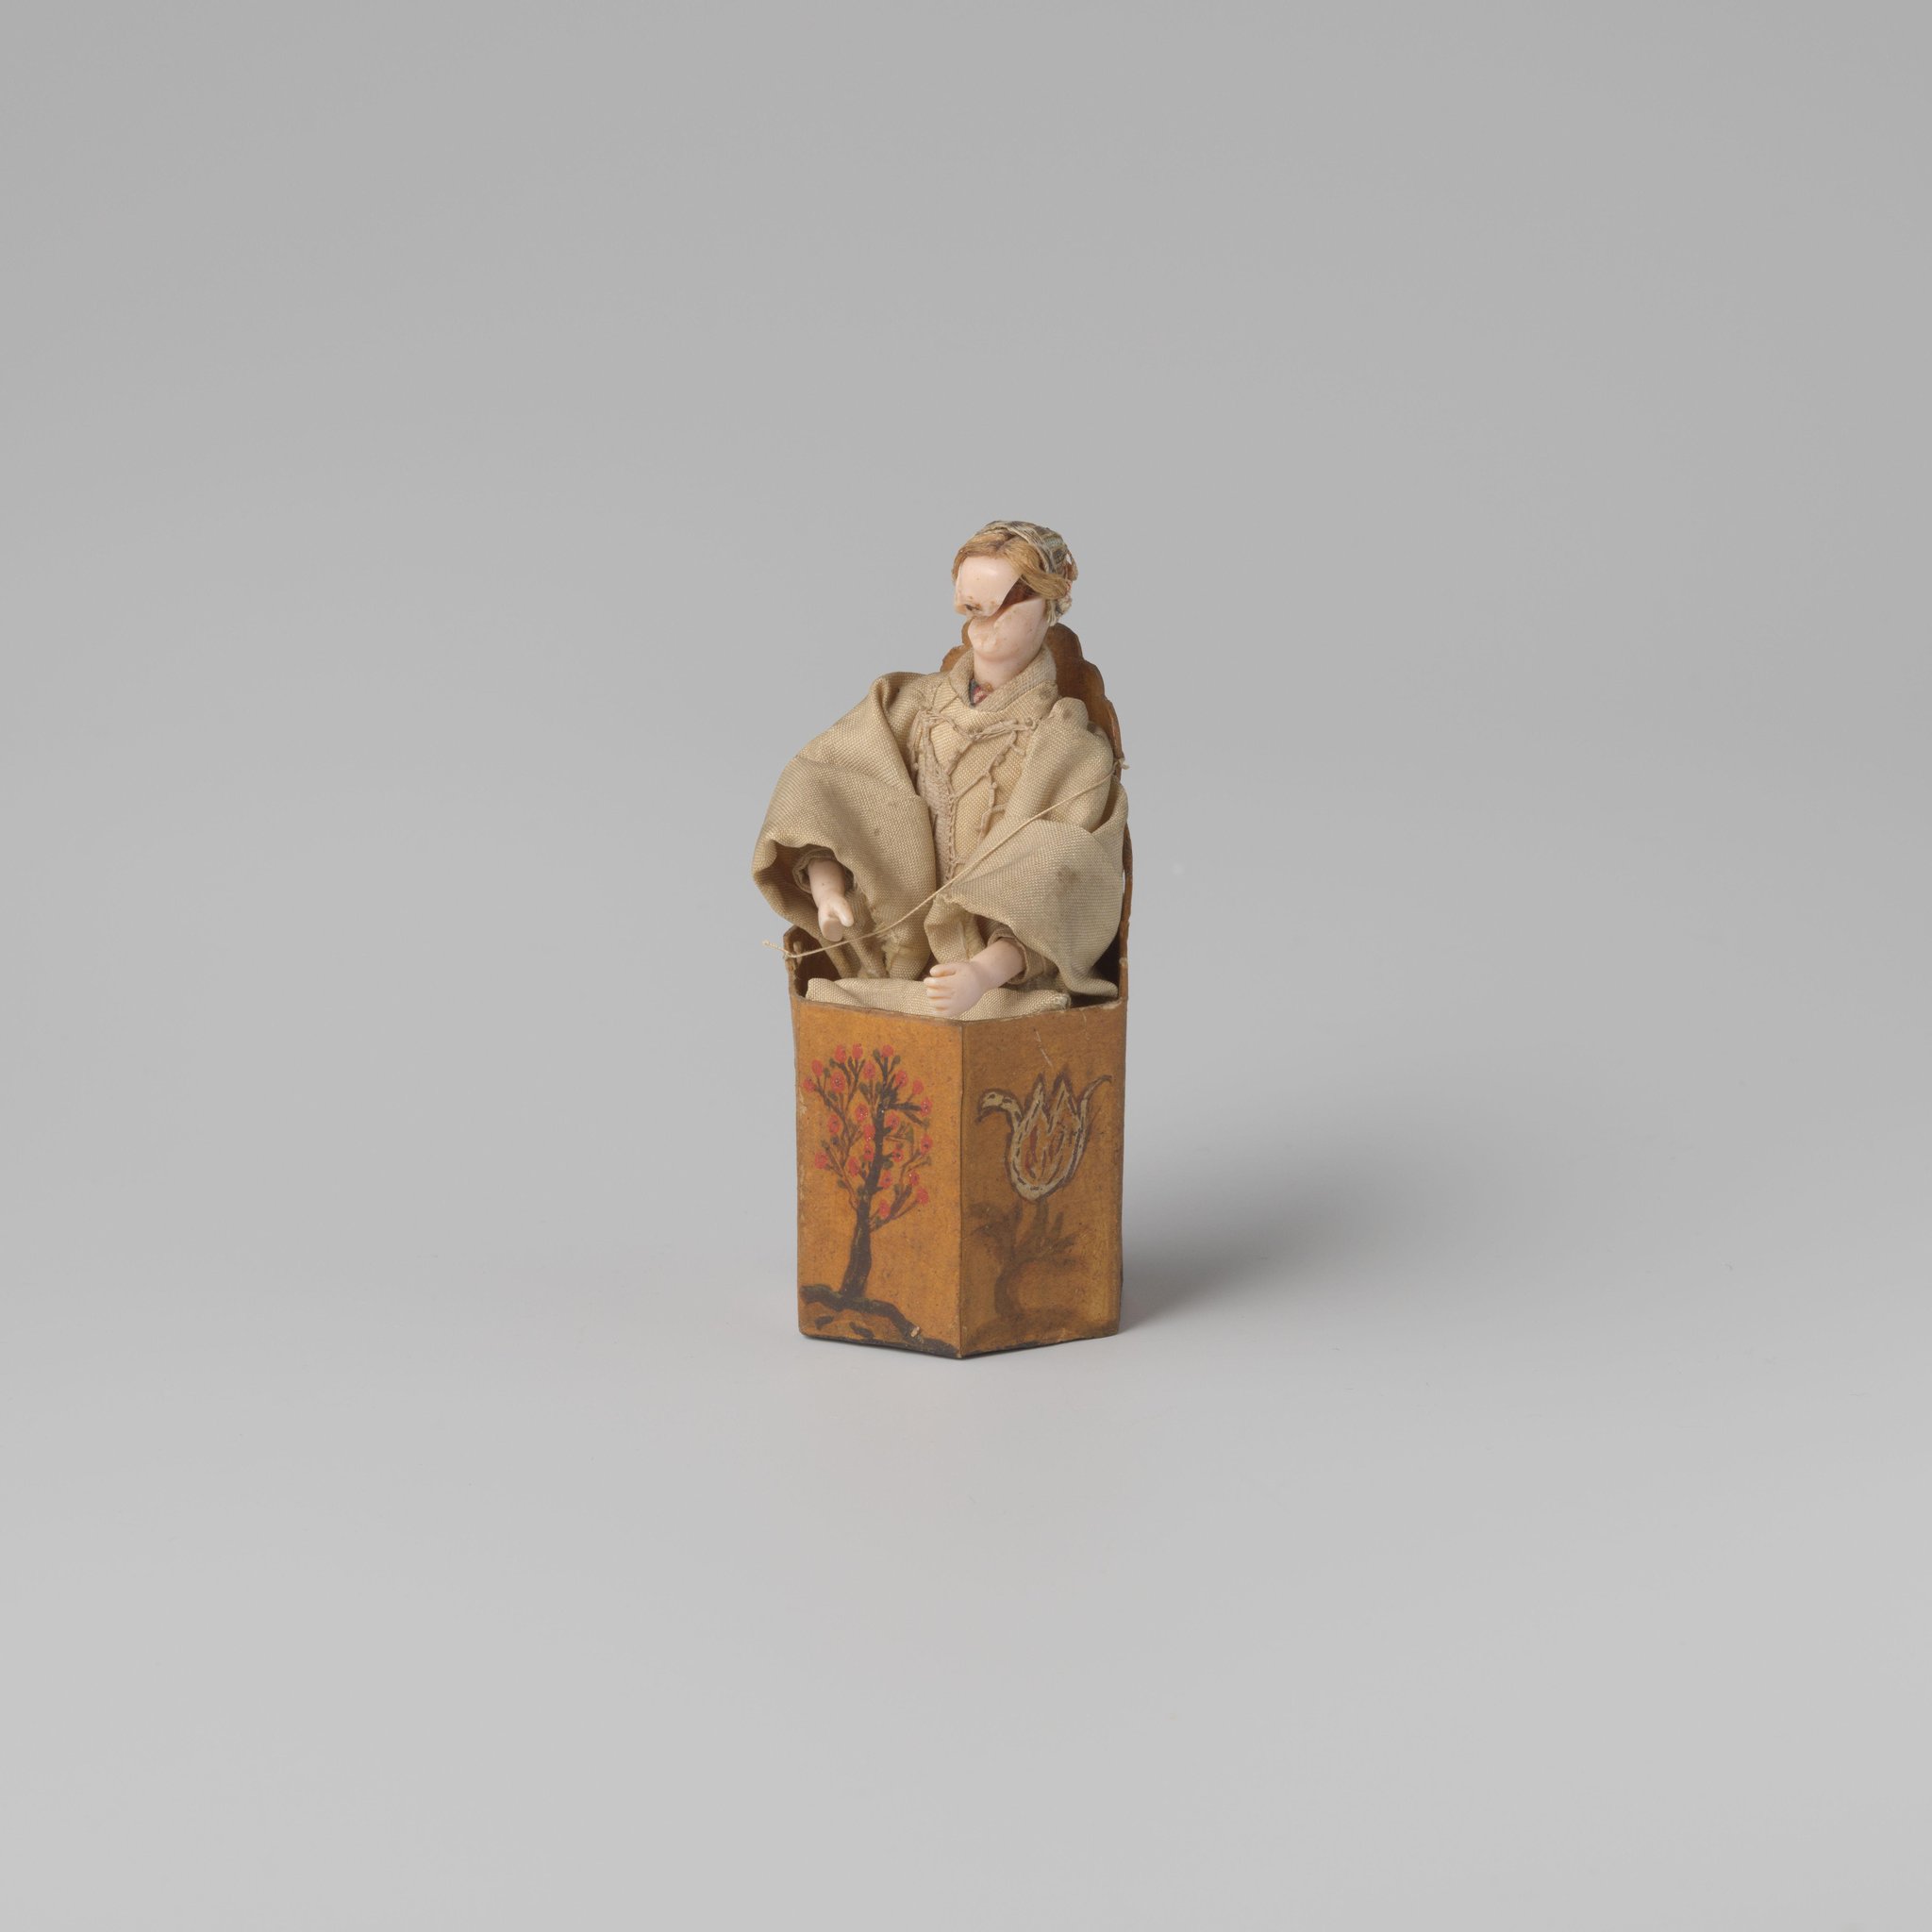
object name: kinderkakstoel, kakstoel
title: Kinderkakstoel vervaardigd van bordpapier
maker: Anonymous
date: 1676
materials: gouache, board, varnish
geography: amsterdam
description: Kinderkakstoel, vervaardigd van bordpapier, zeshoekig, met zitting met gat, voetenplank en rug met gelobte rand, waarin vijf gaten. De stoel is okergeel en beschilderd met twee bomen, twee tulpen en twee guirlandes op de zes zijvlakken.